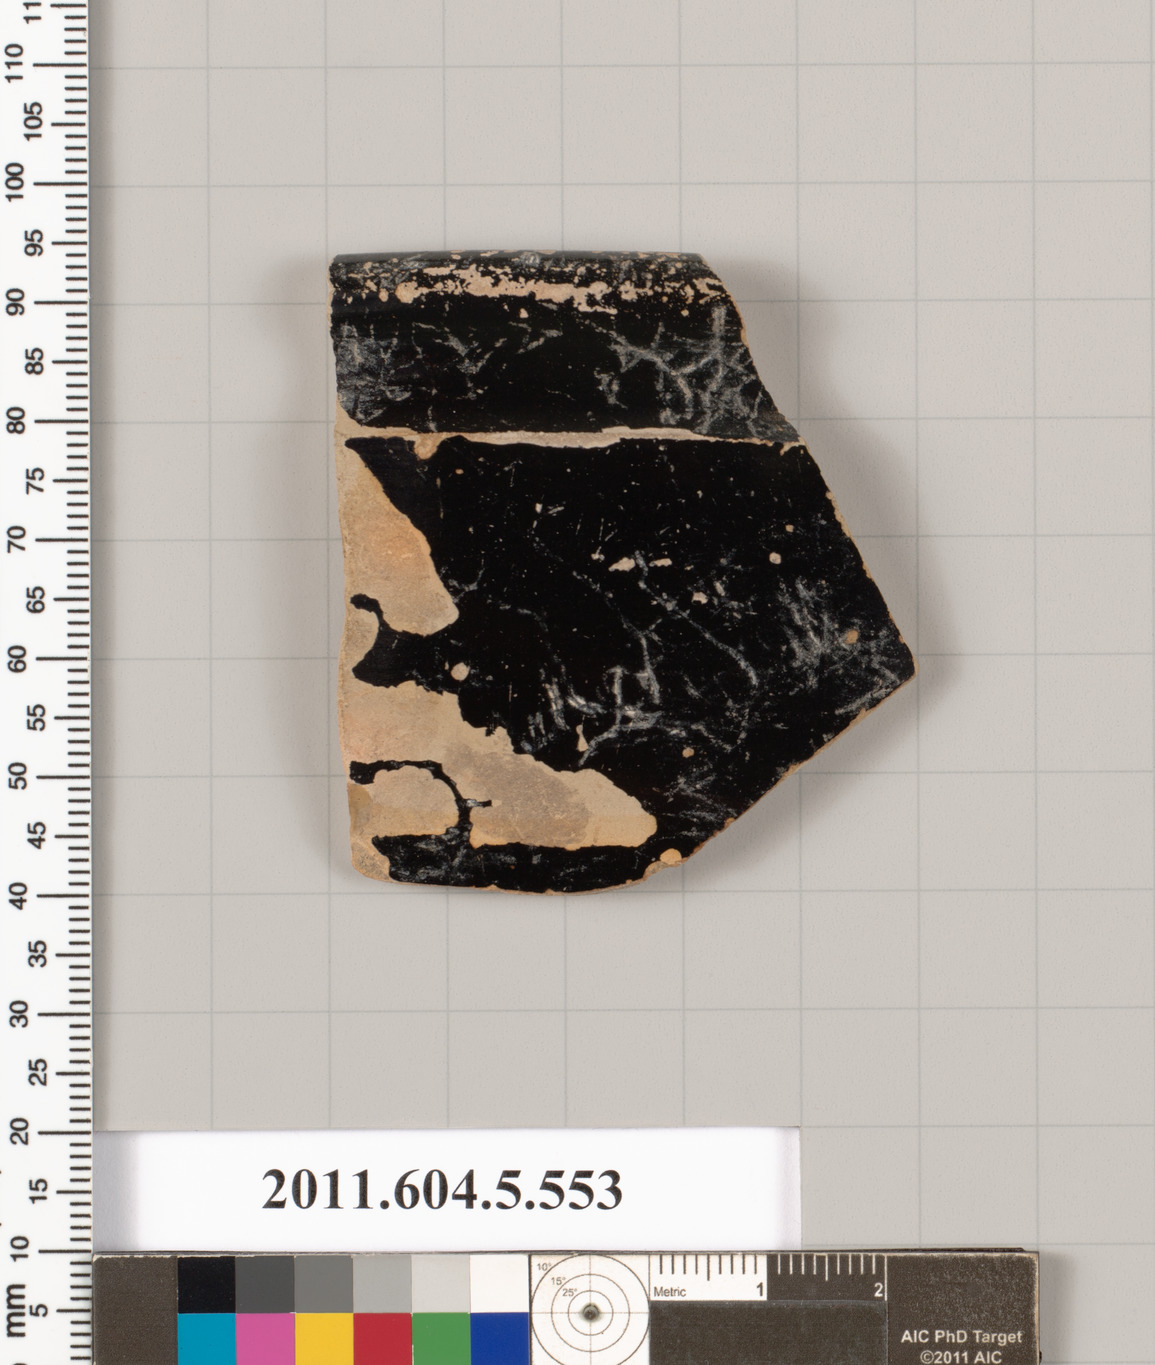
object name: cup skyphos fragment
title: Terracotta rim fragment of a cup-skyphos (drinking cup)?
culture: greek, attic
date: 600-468 BCE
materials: terracotta